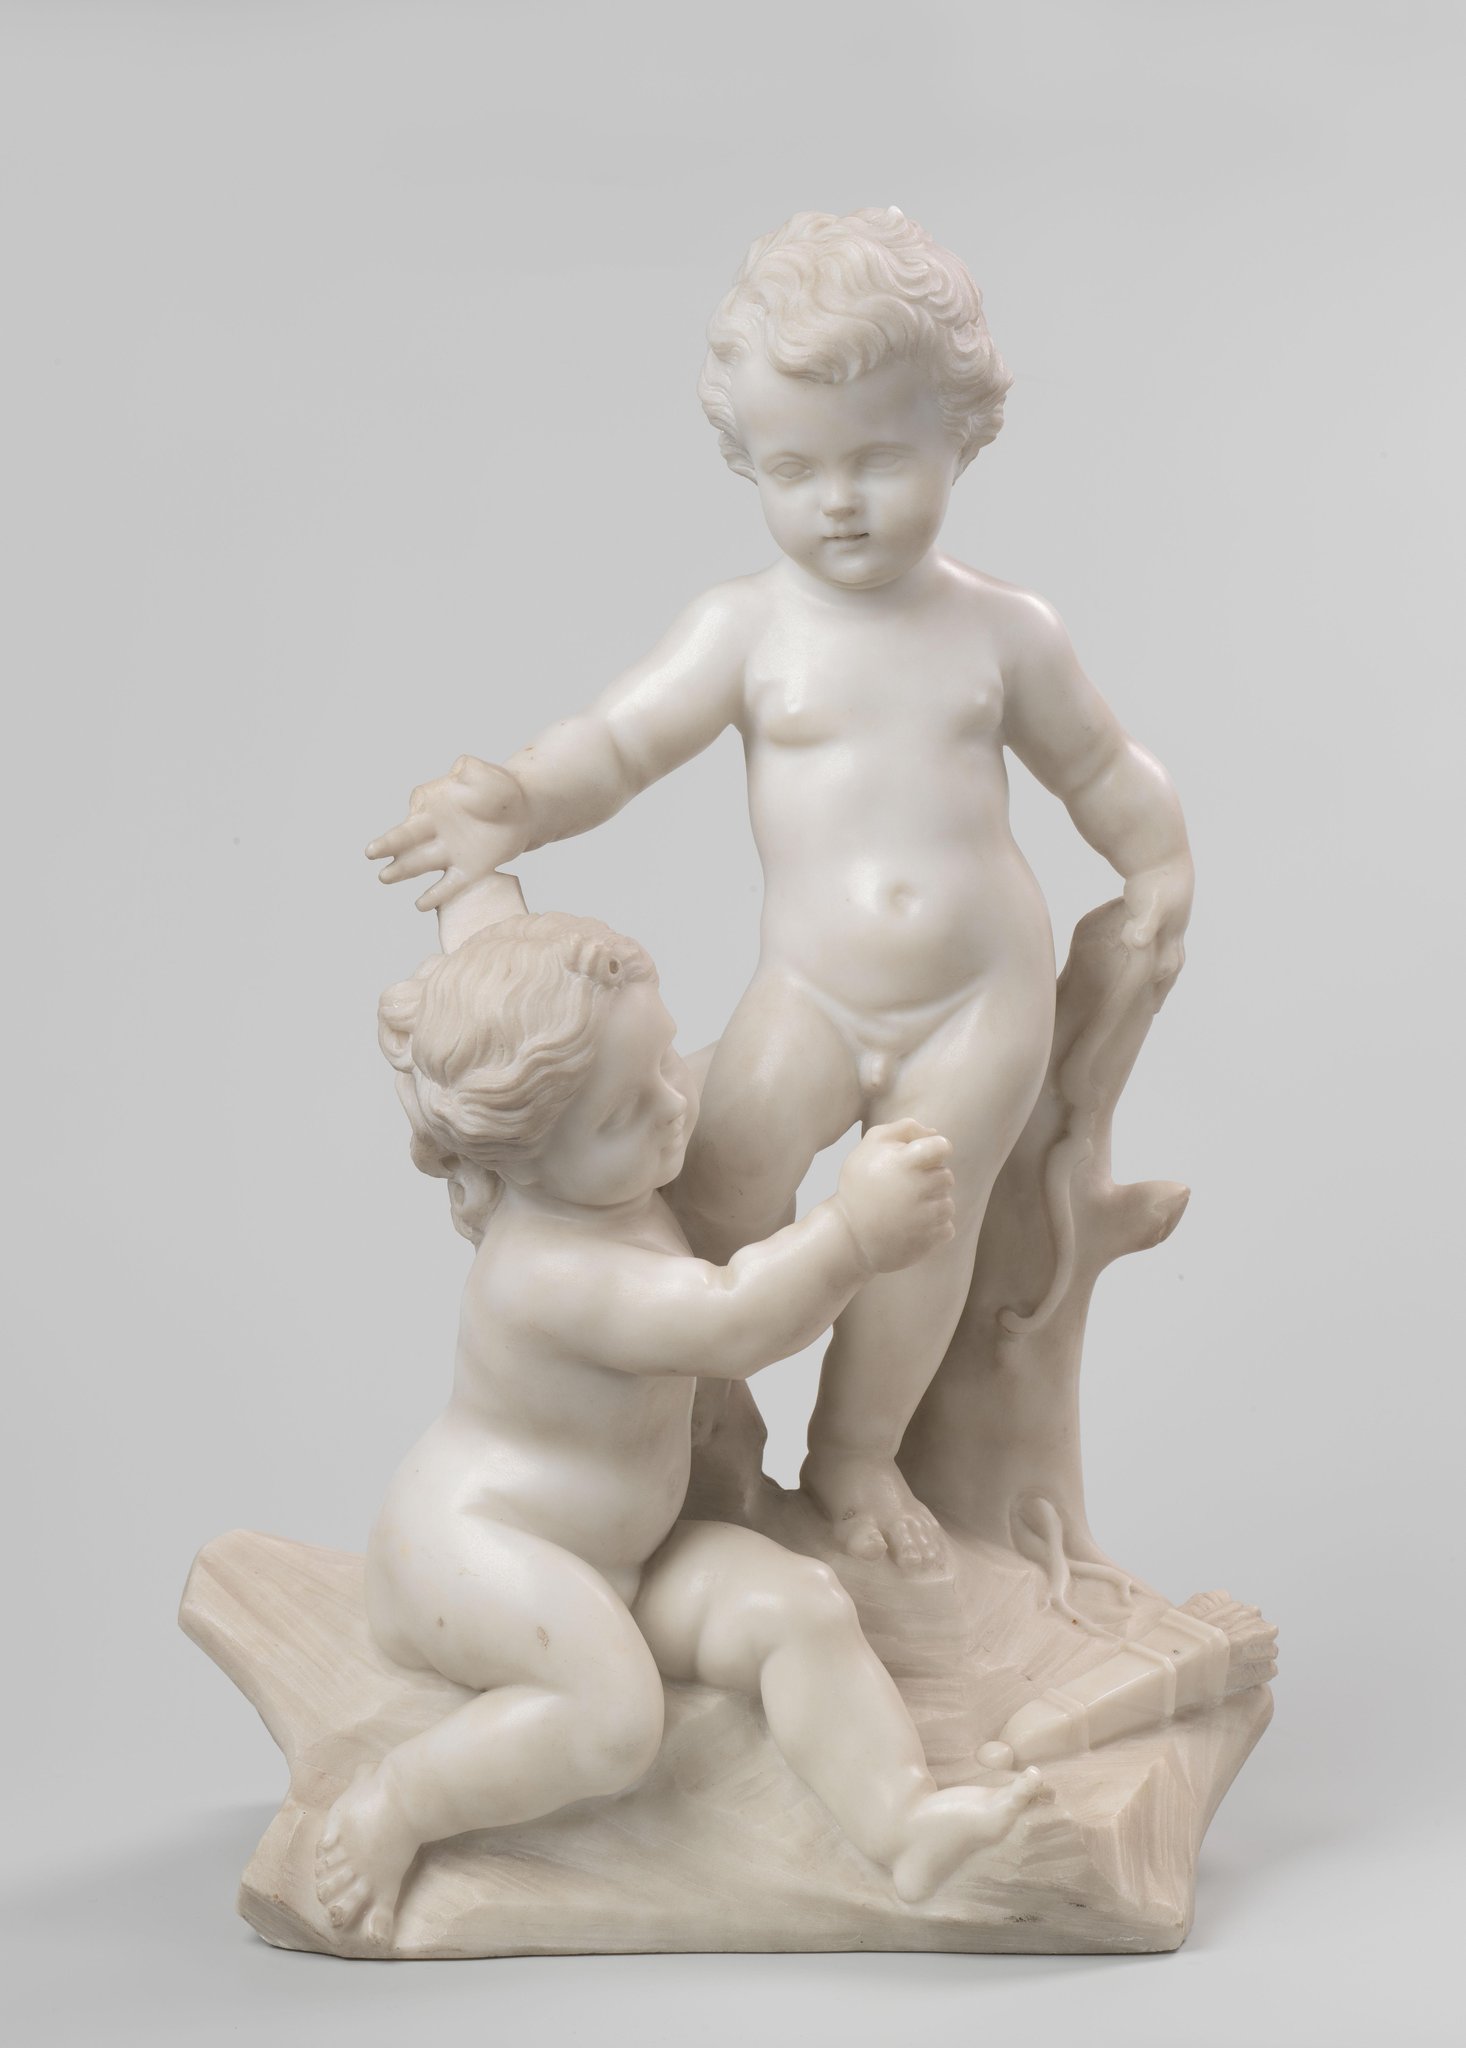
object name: sculpture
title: A Boy and Girl Playing, Allegory of Autumn?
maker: giuseppe sanmartino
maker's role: sculptor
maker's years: 1720-1793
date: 1740-1800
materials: marble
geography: naples